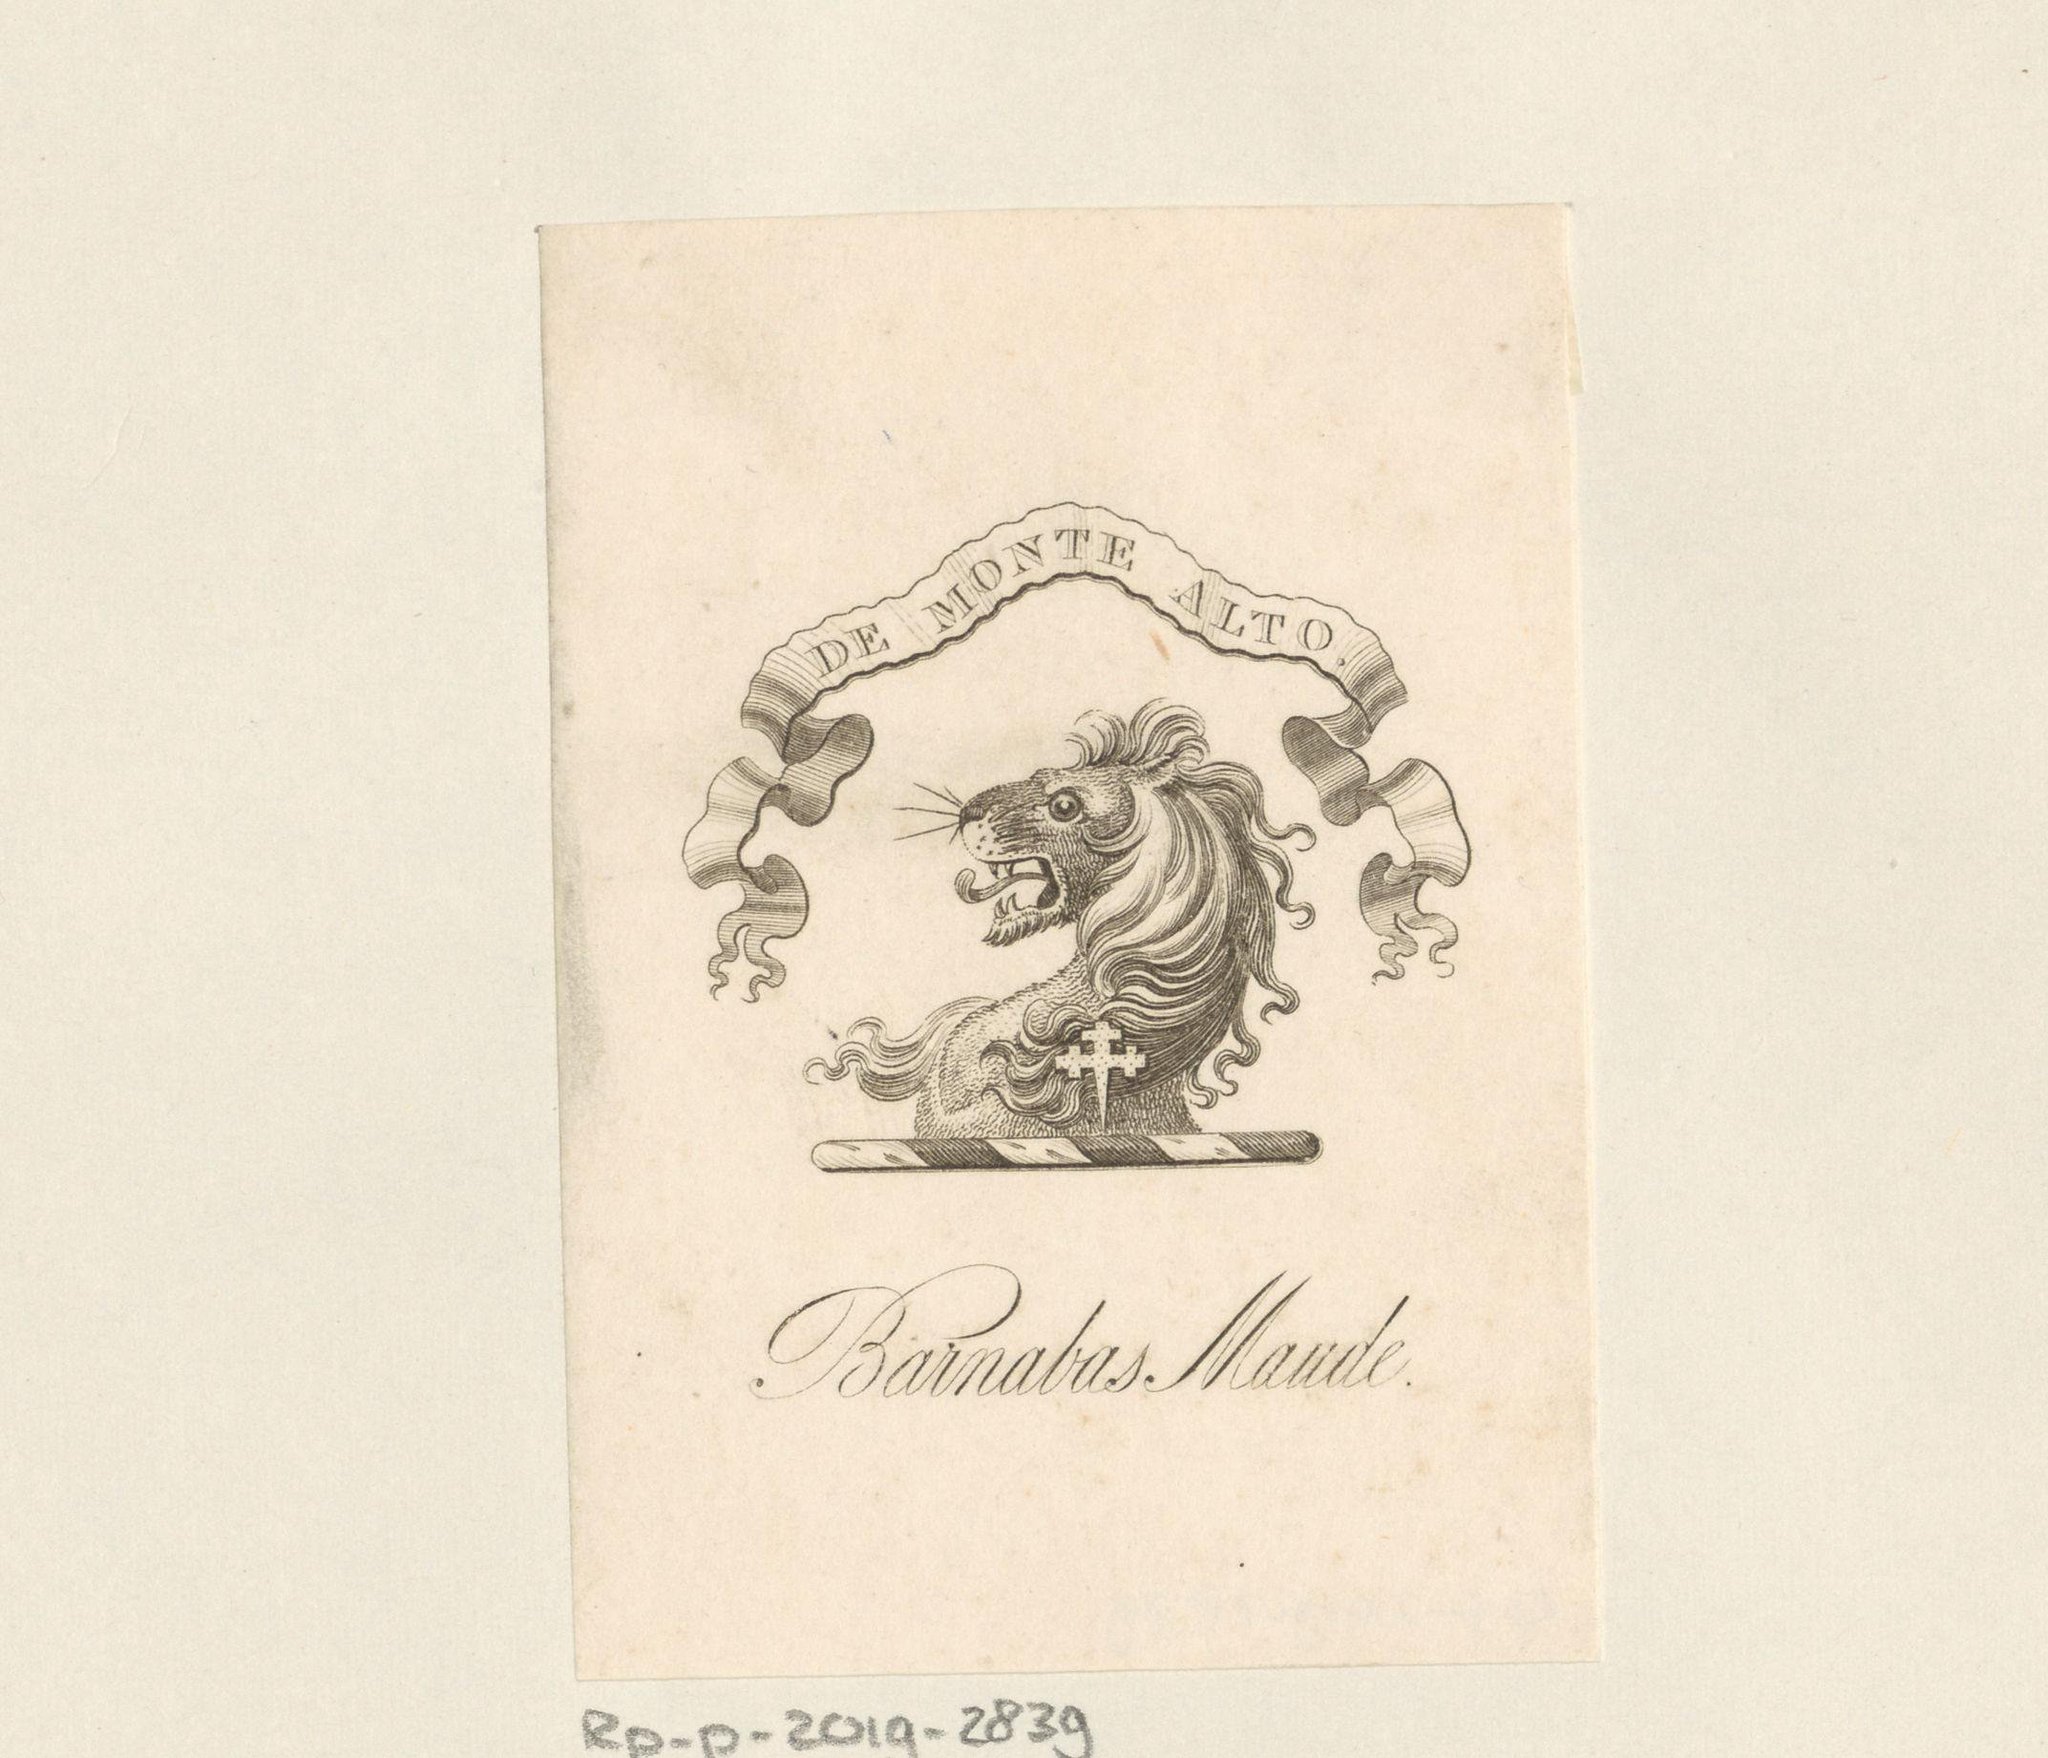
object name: bookplate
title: Ex libris van Barnabas Maude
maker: Anonymous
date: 1800-1899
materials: paper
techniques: etching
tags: beasts of prey, predatory animals: lion